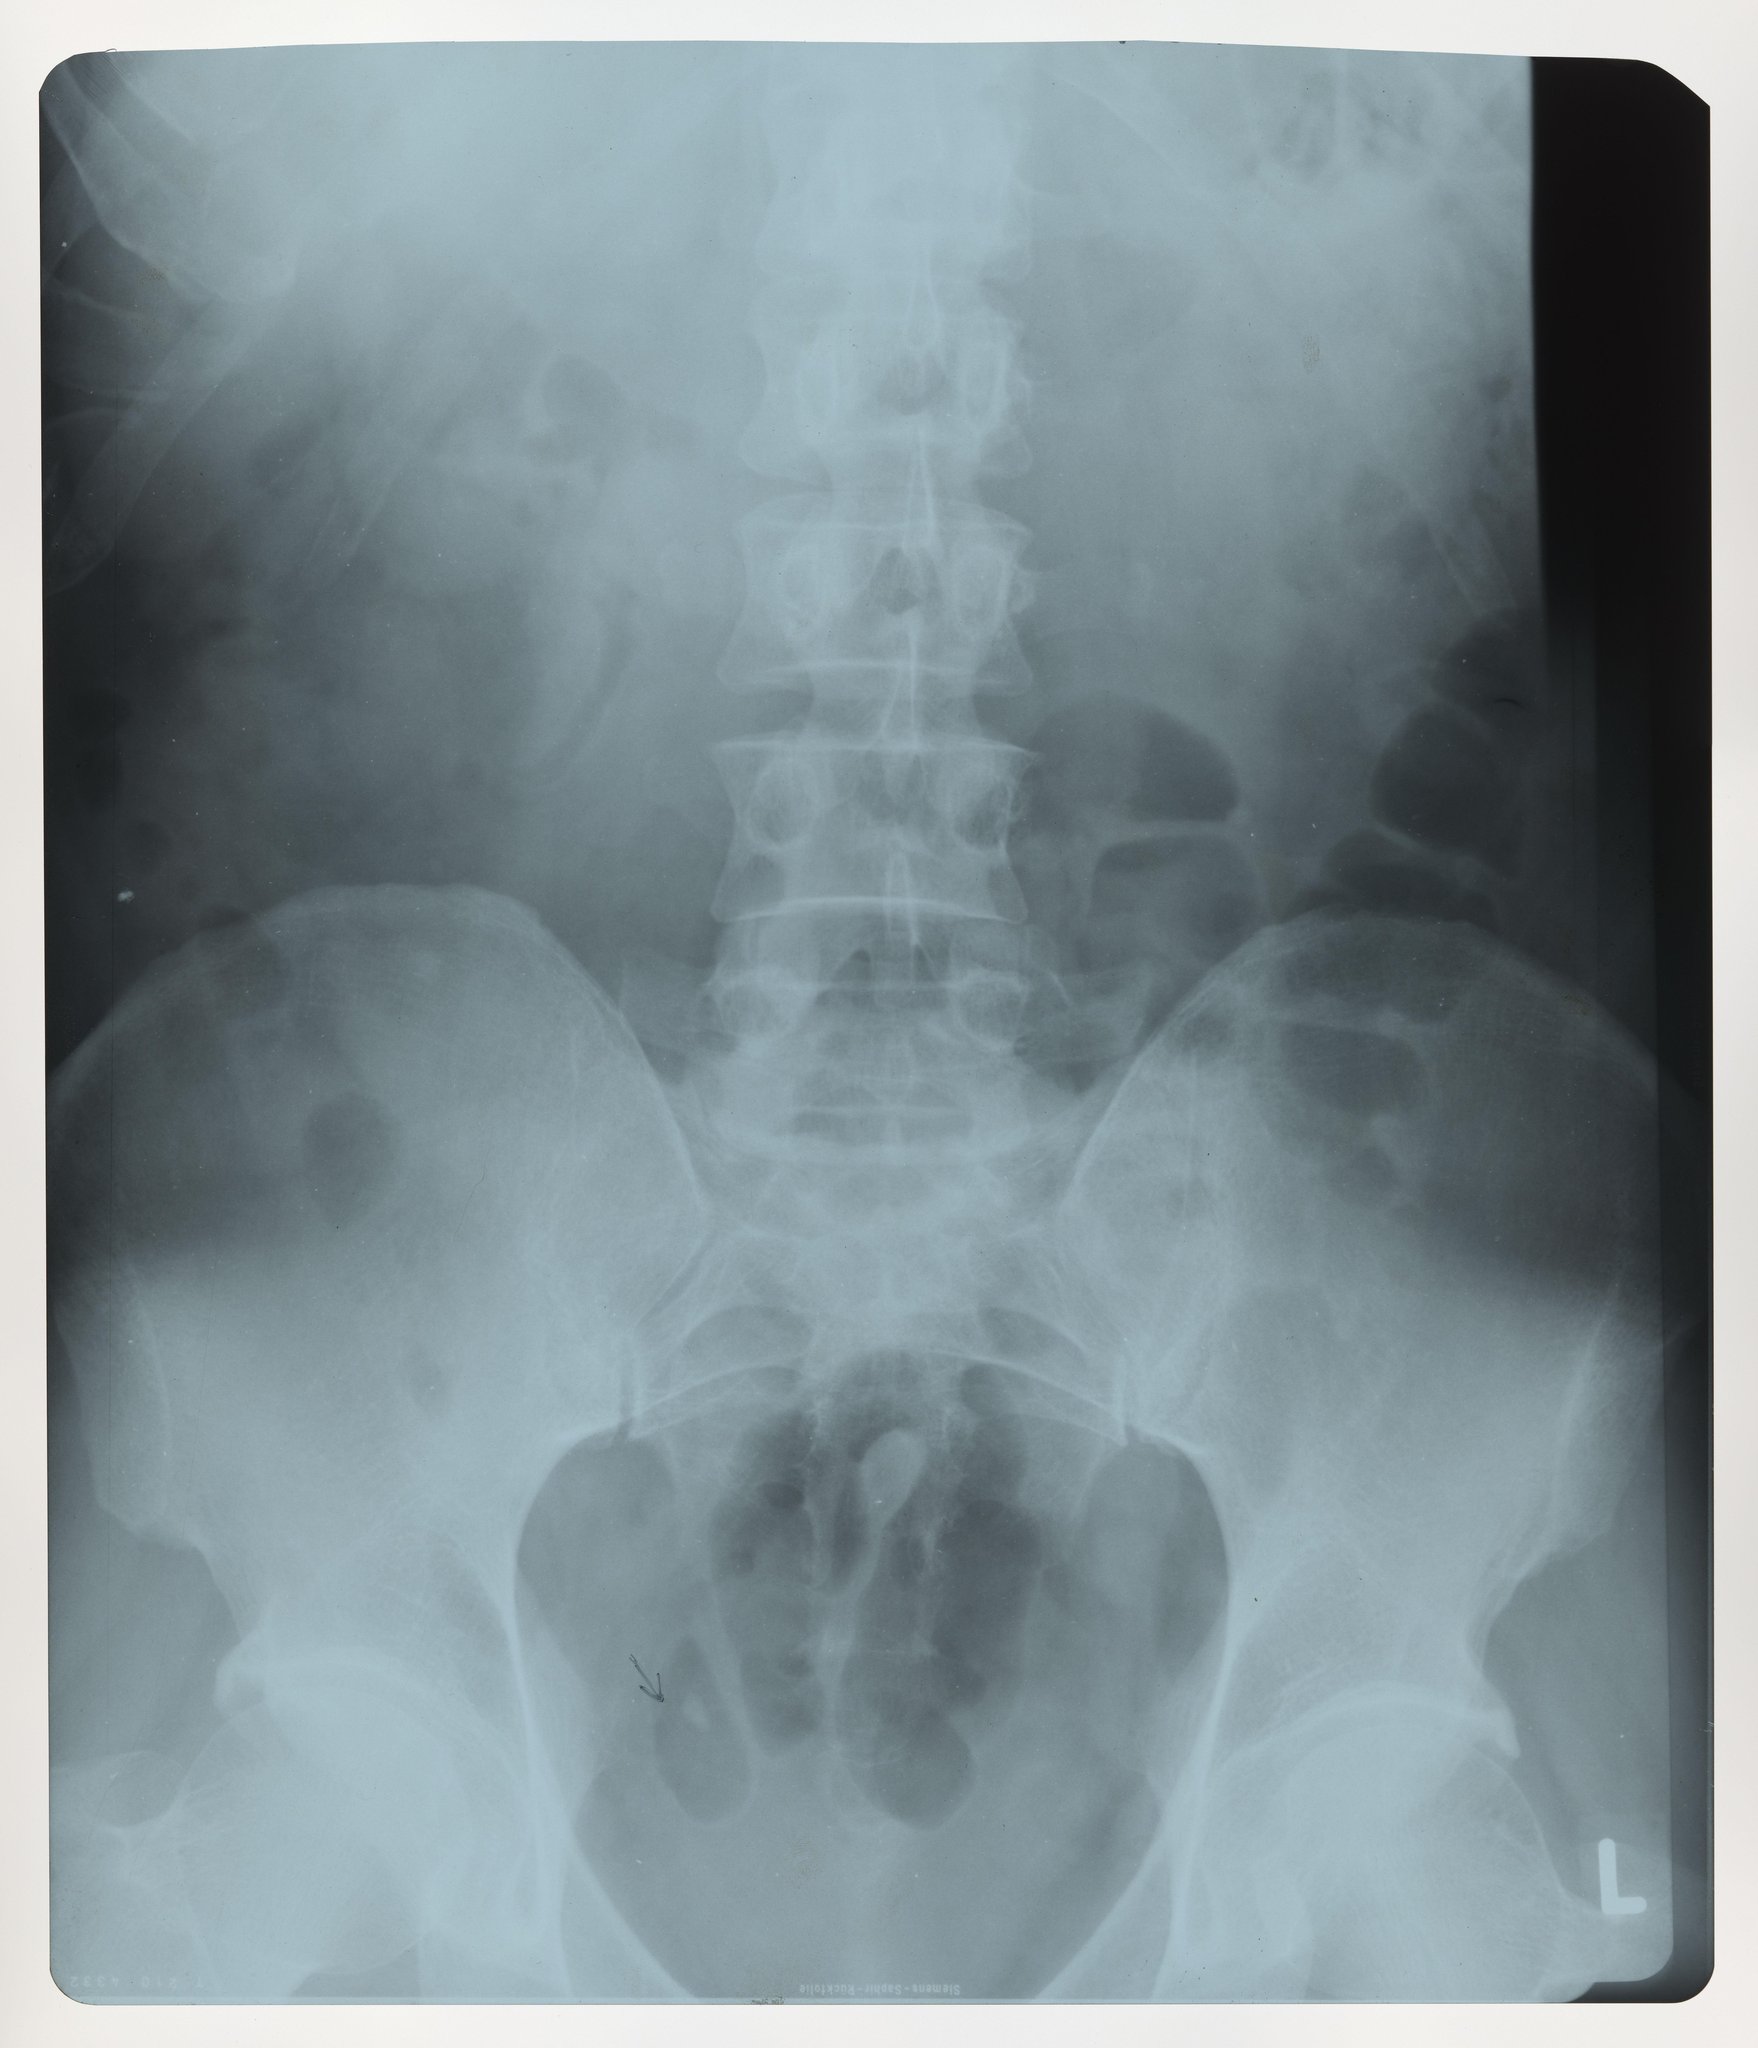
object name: x ray photograph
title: Röntgenopname van een menselijk bekken, linksonder met pijl aangegeven de galblaas met steen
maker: Anonymous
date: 1910-1980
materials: plastic, film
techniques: gelatin silver negative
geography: amsterdam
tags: pelvis, gall bladder